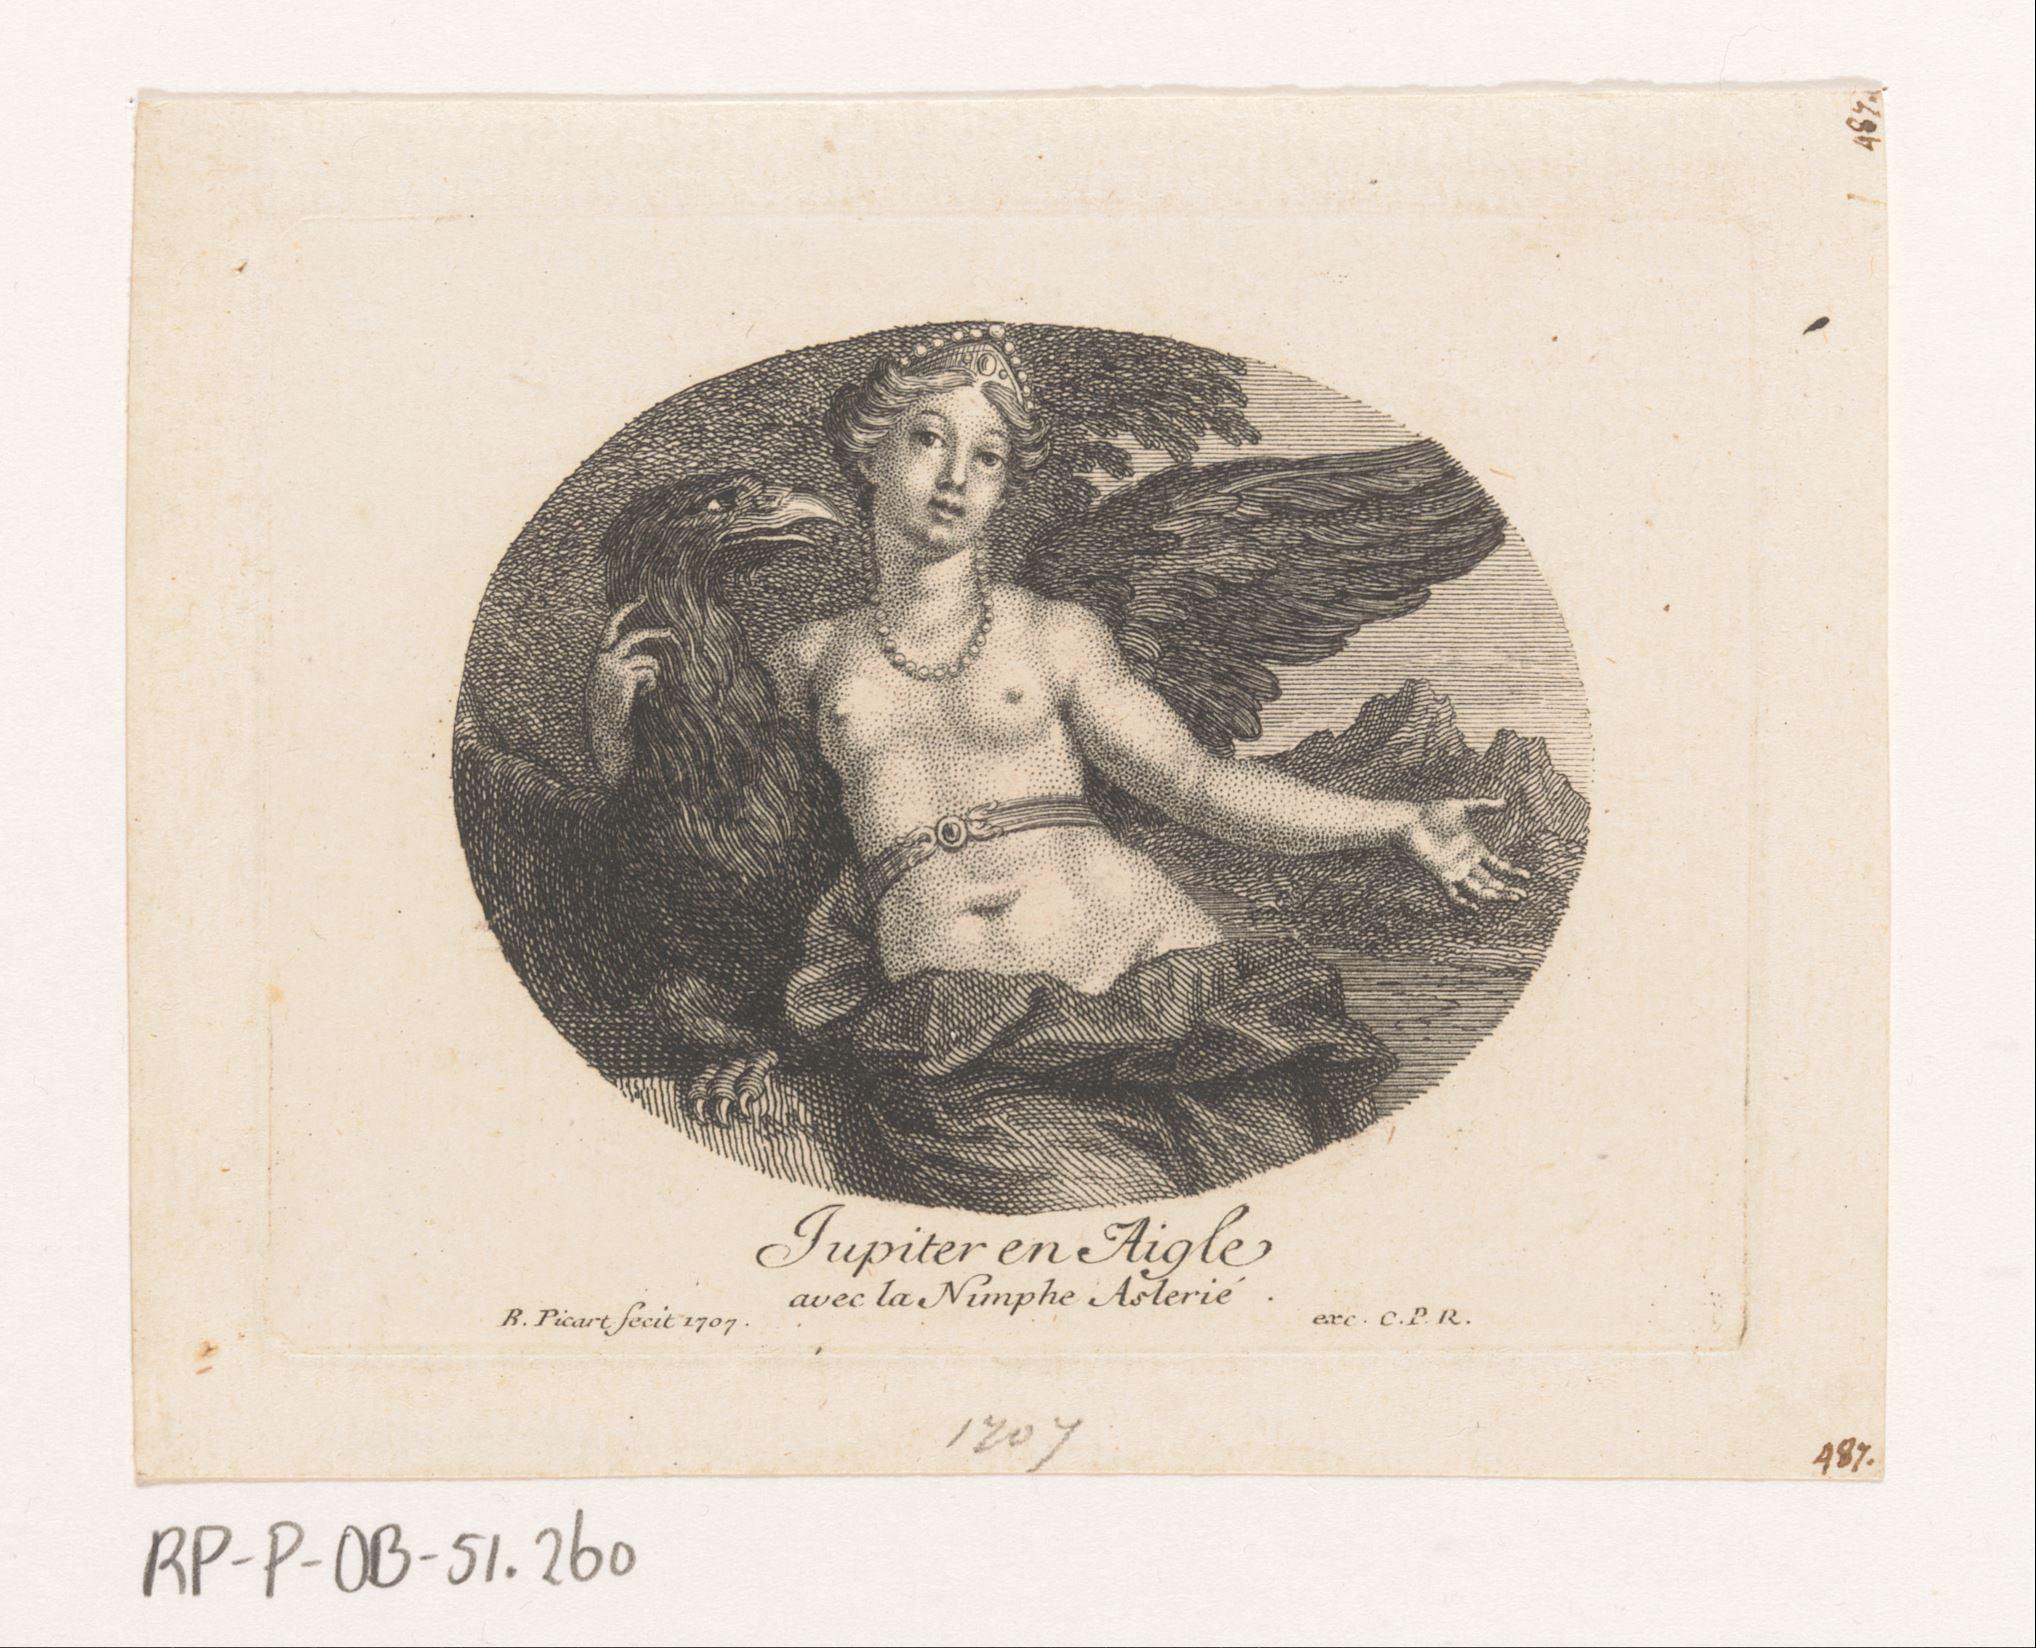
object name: print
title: Jupiter en Aigle avec la Nimphe Asterié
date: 1707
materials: paper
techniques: engraving, etching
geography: paris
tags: jupiter, in the form of an eagle, wrestles with asteria (as yet not metamorphosed)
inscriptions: collector's mark: Lugt 2228, number: ‘487’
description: Prent is mogelijk opgenomen in een editie van: Fénelon, François de Pons de Salignac de la Mothe. Les aventures de Télémaque.